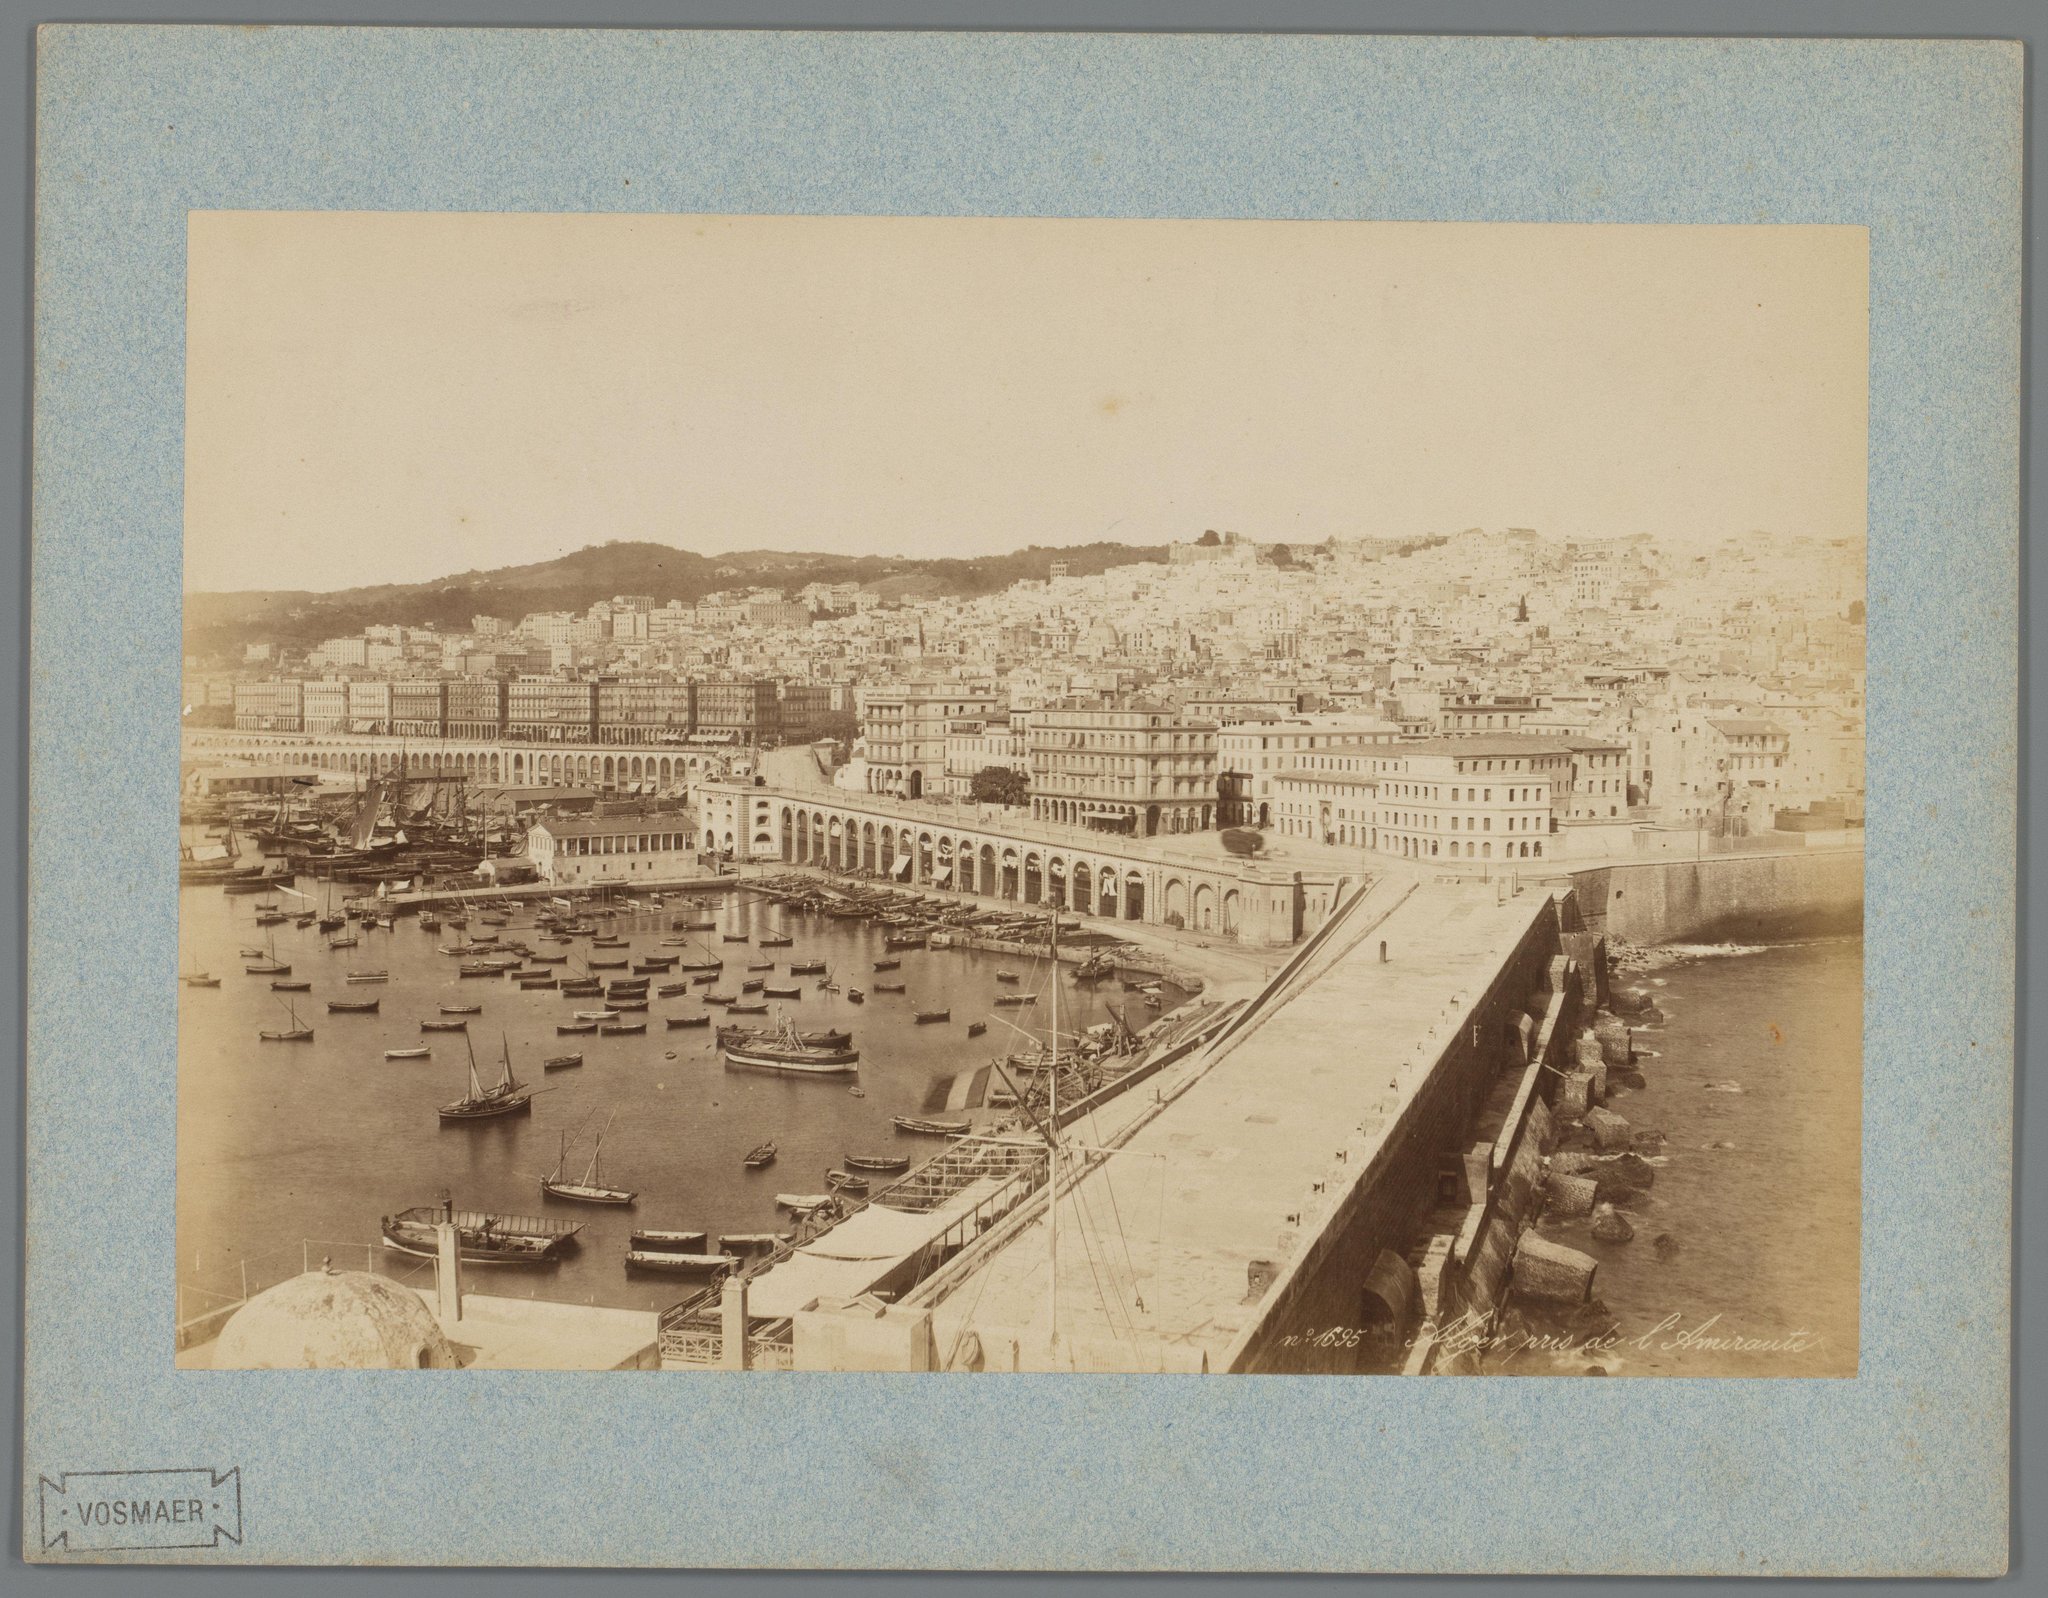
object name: photograph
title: Gezicht op Algiers vanuit de haven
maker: Anonymous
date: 1851-1900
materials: cardboard, paper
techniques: albumen print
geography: algiers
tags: harbour, city-view in general; 'veduta', ships (in general) - cc - more than one ship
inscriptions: collector's mark: ‘VOSMAER’, number: ‘no 1595’